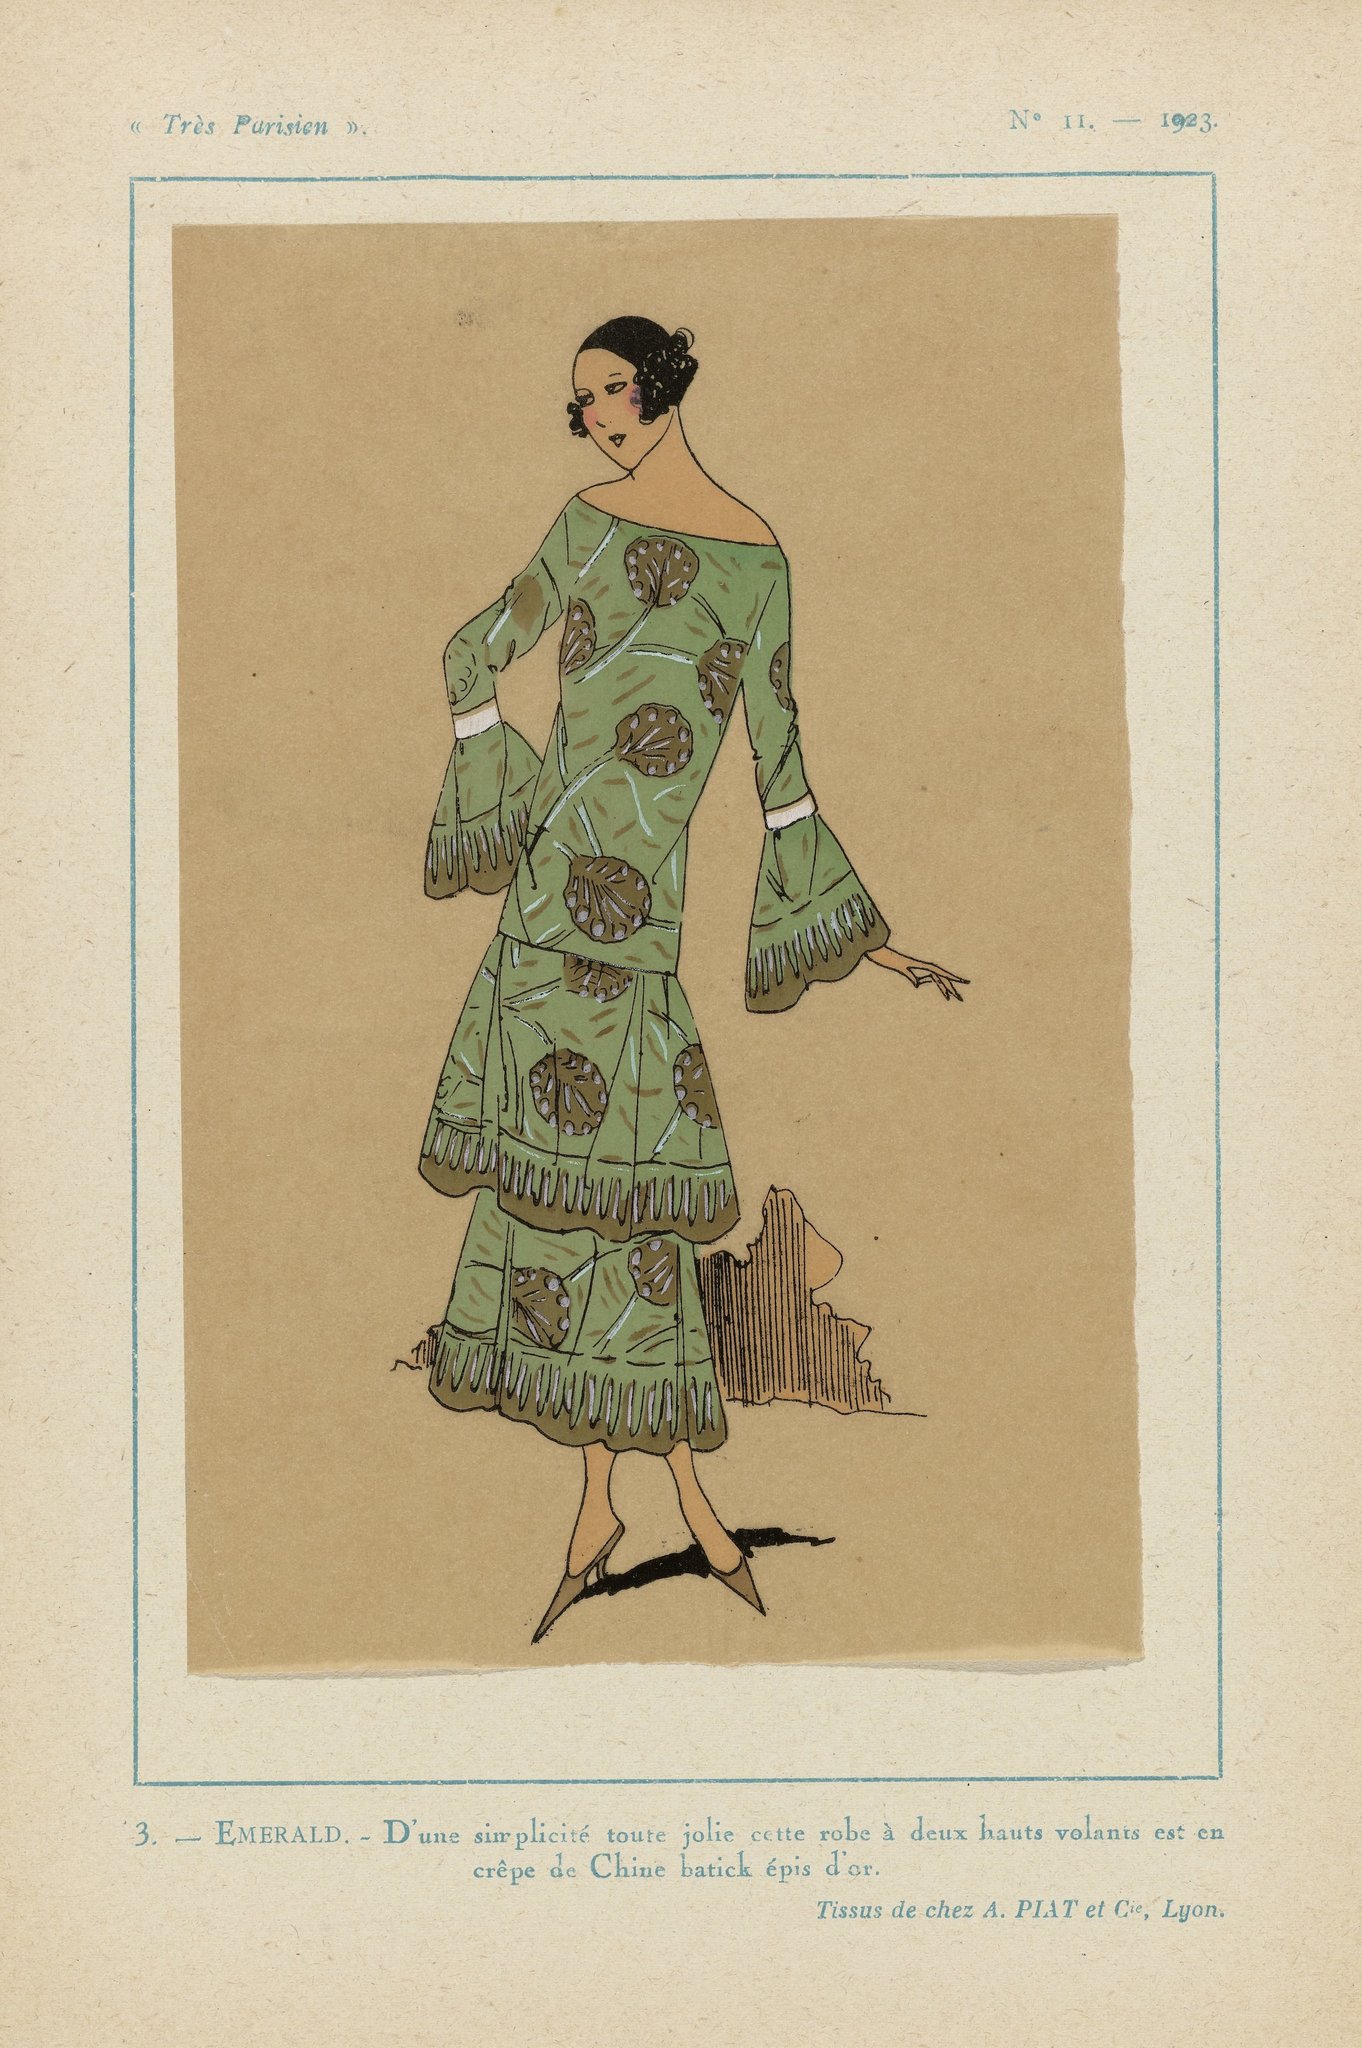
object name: fashion print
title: Très Parisien, 1923, No 11: 3. - EMERALD. - D'une simplicité toute jolie...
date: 1923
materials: paper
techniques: hand coloring, letterpress printing, lithography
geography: lyon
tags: fashion plates, dress, gown (+ women's clothes)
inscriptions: title: ‘Très Parisien / No 11. - 1923’, caption: ‘3. - EMERALD. - D'une simplicité toute jolie cette robe à deux hautes volants est en crêpe de Chine batick épis d'or. / Tissus de chez A. PIAT et Cie, Lyon.’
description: Jurk met twee brede volants van 'crêpe de Chine batick épis d'or'. Stoffen van A. Piat. Prent uit het modetijdschrift Très Parisien (1920-1936).